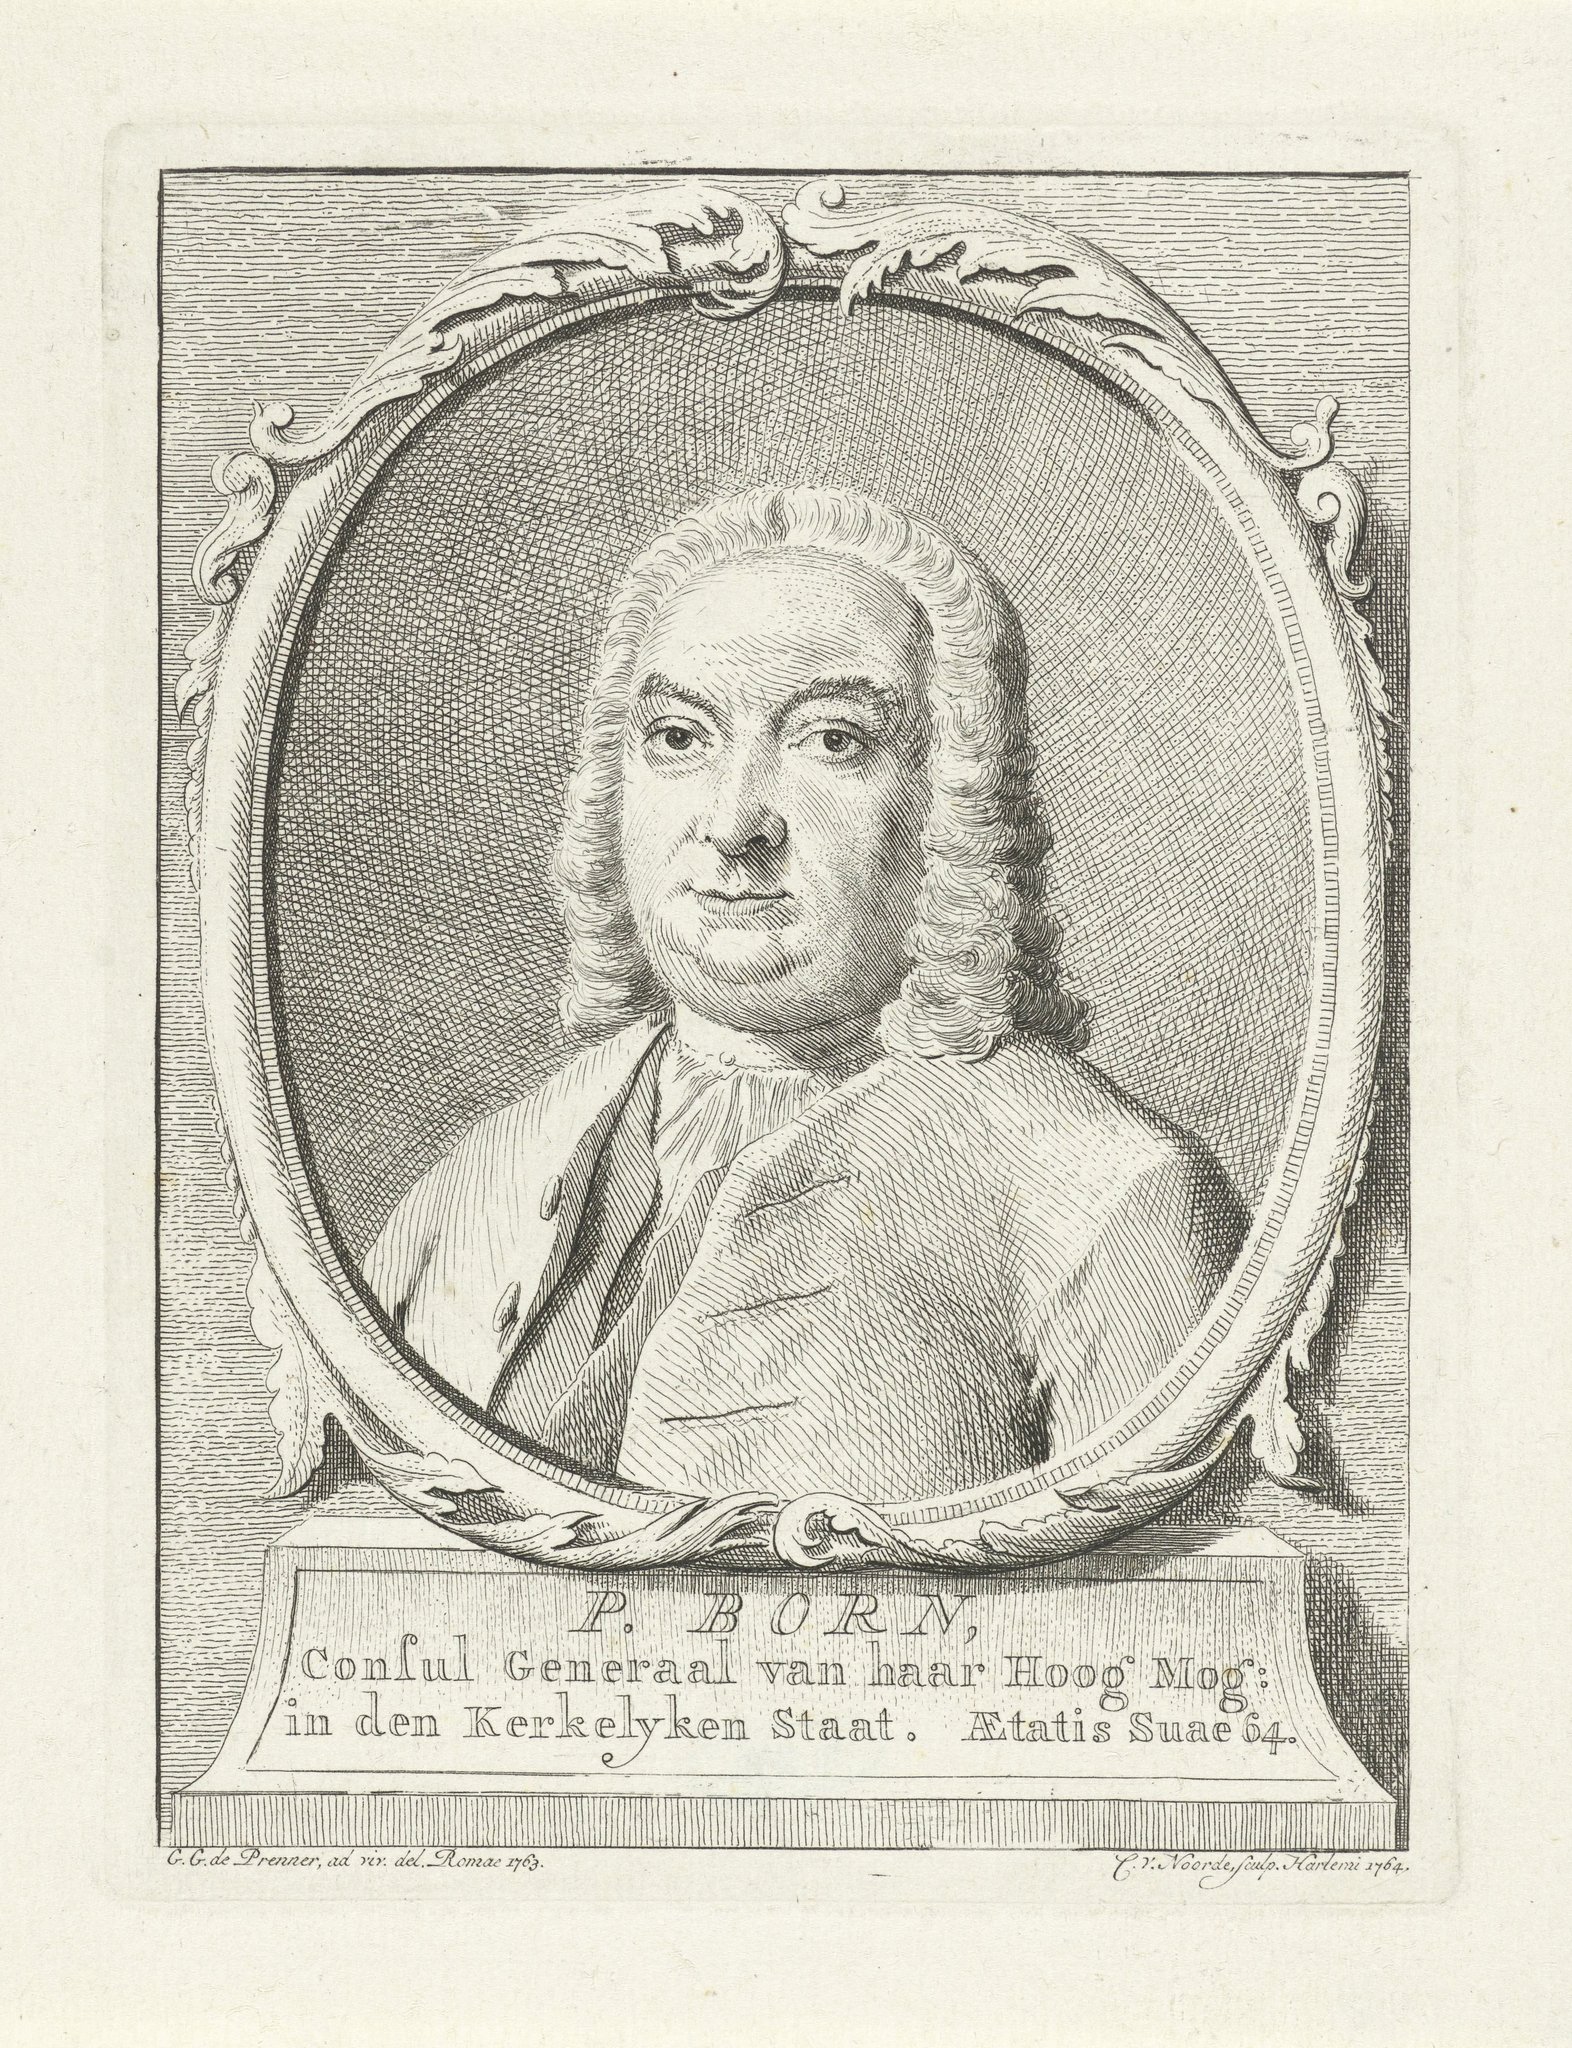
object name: print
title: Portret van P. Born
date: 1764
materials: paper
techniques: etching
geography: haarlem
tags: consul-generaal, p. born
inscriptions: collector's mark: Lugt 2228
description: Portret van P. Born, consul-generaal van de kerkelijk staat, op 64-jarige leeftijd met een pruik op het hoofd.